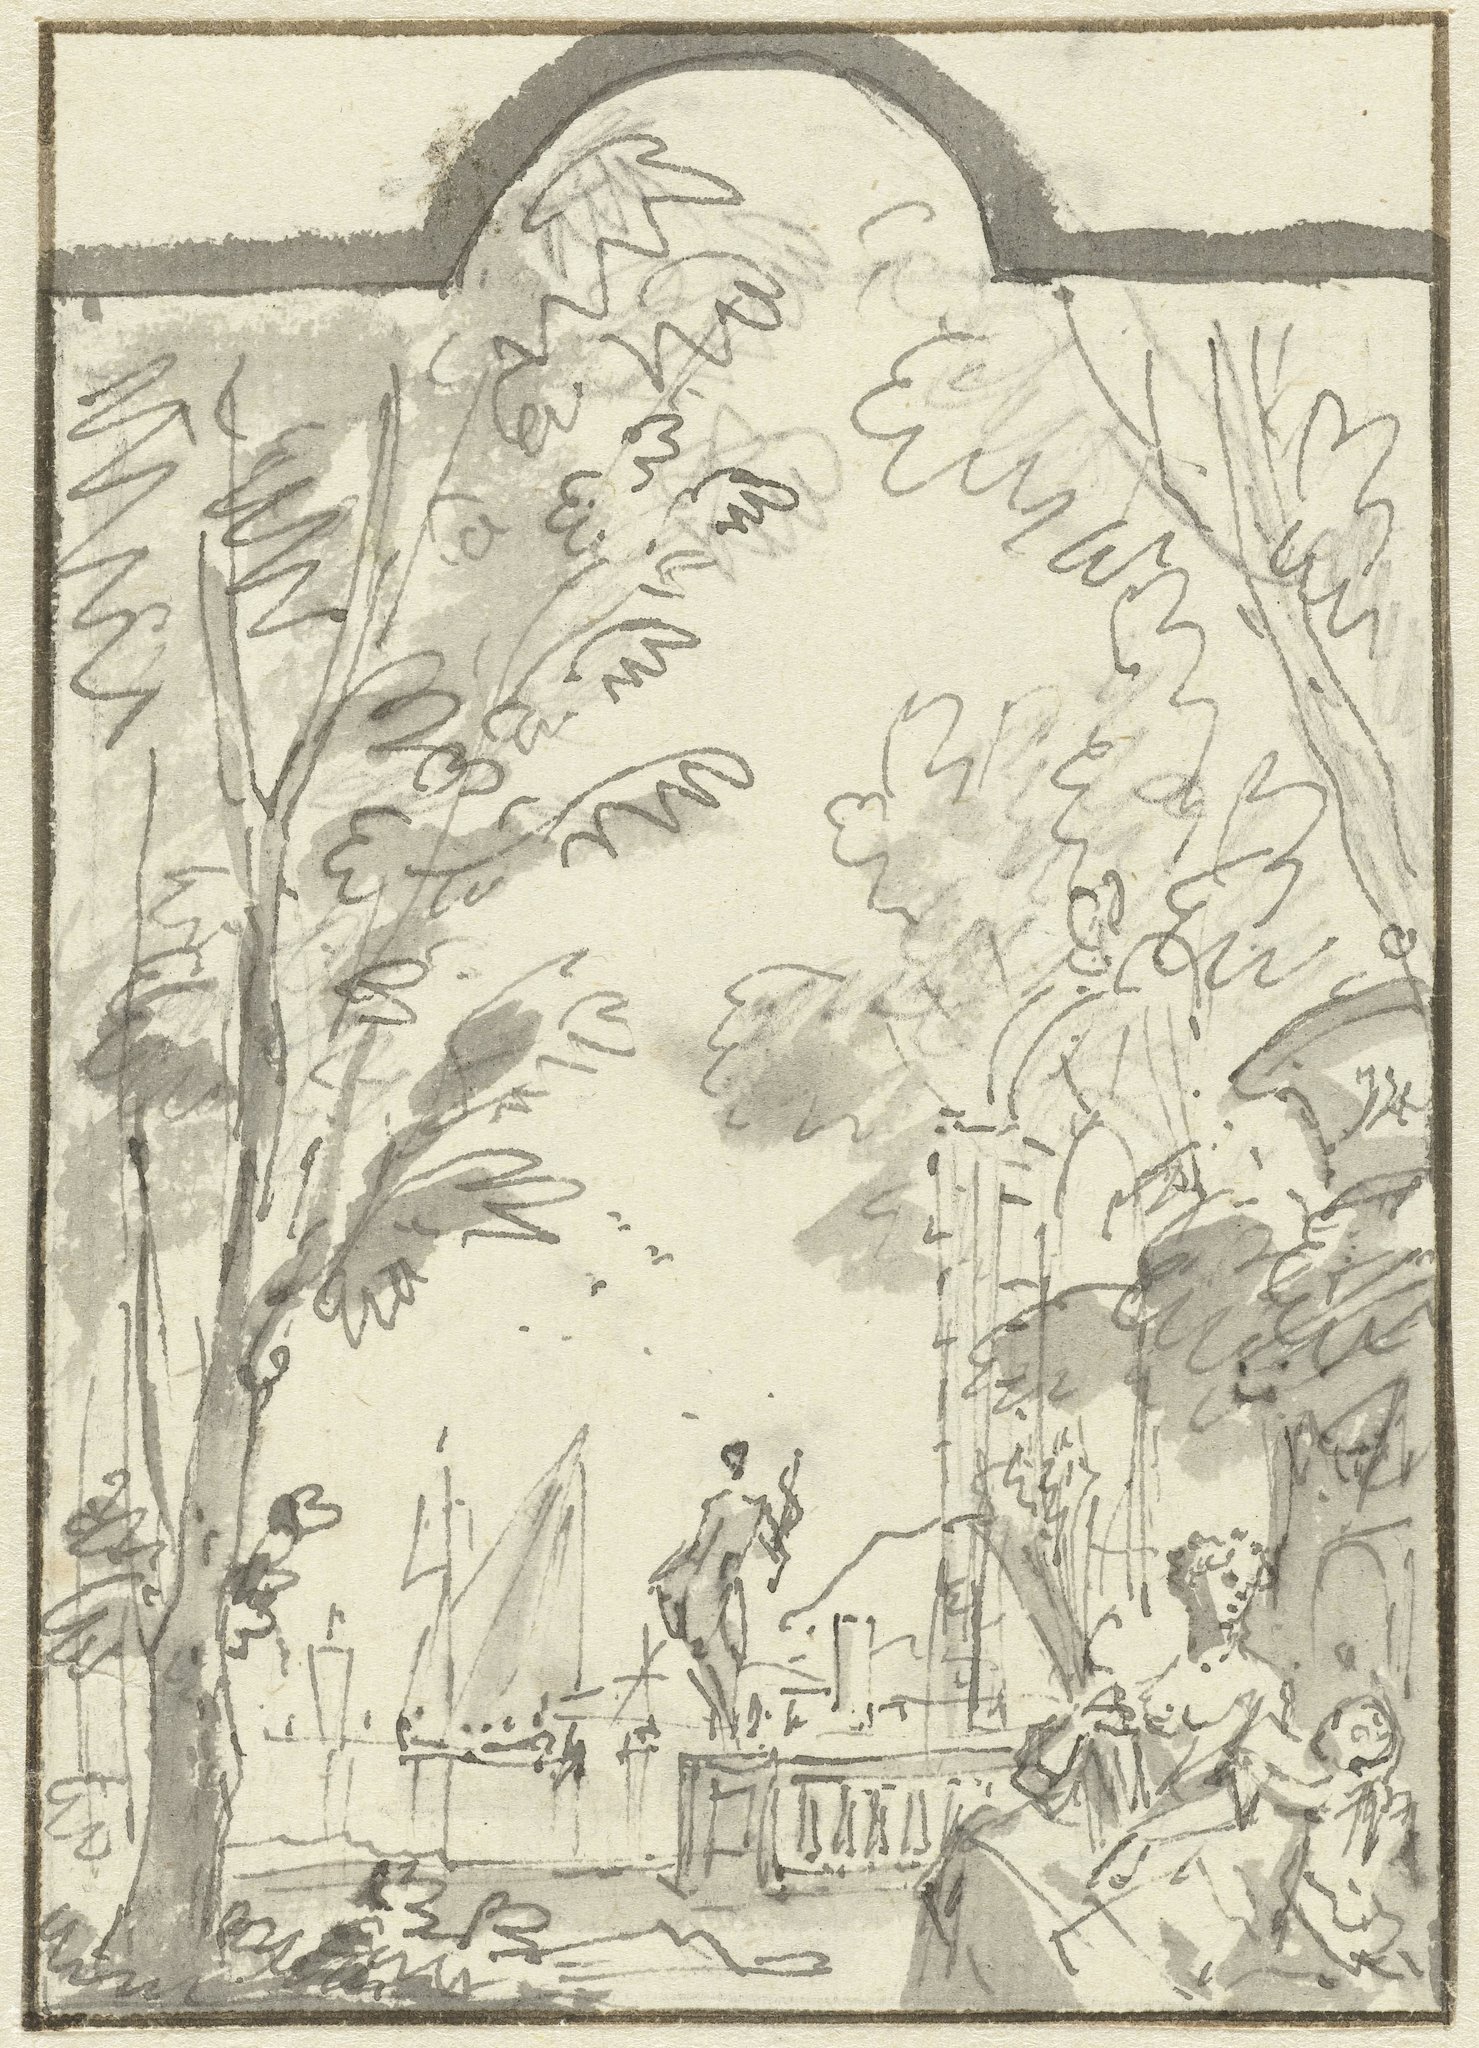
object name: design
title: Ontwerp voor een behangselbeschildering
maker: isaac de moucheron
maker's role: draughtsman, painter, print maker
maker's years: 1667-1744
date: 1677-1744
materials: ink, paper, pencil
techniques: brush, pen